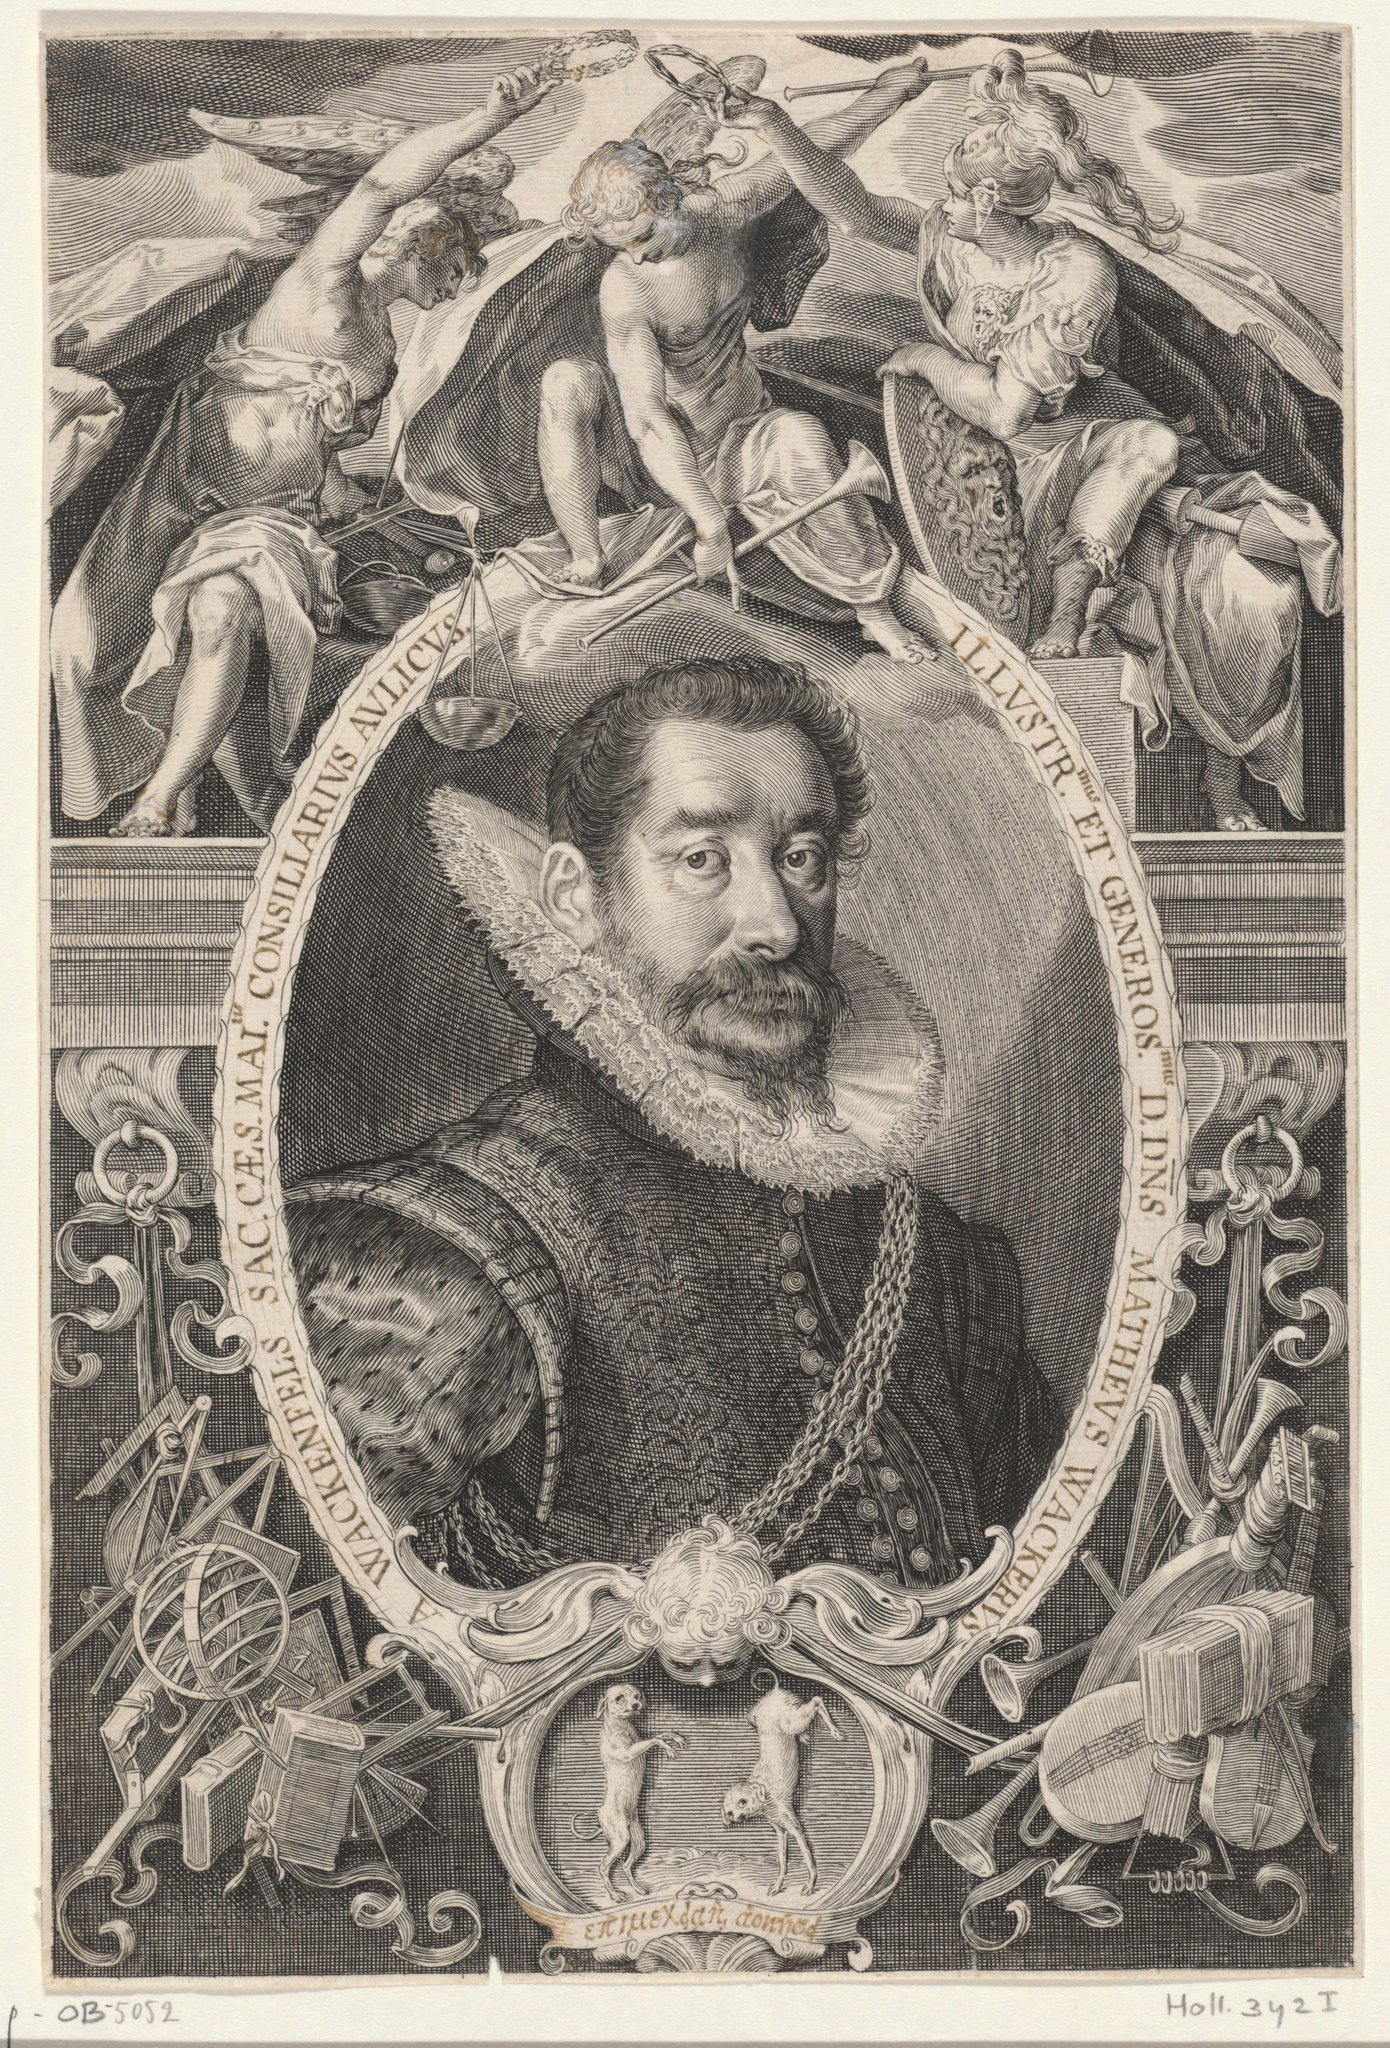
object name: print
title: Portret van Matthaeus Wacker von Wackenfels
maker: aegidius sadeler (ii)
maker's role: draughtsman, print maker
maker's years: 1568-1629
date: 1597-1629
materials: paper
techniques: engraving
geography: prague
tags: musical instruments; group of musical instruments, symbolic representations, allegories and emblems ~ science, 'scientia'; 'scienza', 'studio' (ripa), (story of) minerva (pallas, athena), neck-gear ~ clothing (with name) (+ men's clothes), justice; 'forza alla giustitia sottoposta', 'giustitia', 'giustitia retta', 'giustitia rigorosa', 'impietà e violenza soggetta alla giustitia' (ripa), fame; 'fama', 'fama buona', 'fama chiara' (ripa), dog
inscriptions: collector's mark: Lugt 240, inscription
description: Matthaeus Wacker von Wackenfels (evt. de broer van Johannes Matthaeus Wacker). Boven het portret drie allegorische figuren die lauwerkransen ophouden (Justitia, Fama en Minerva). Rond het portret attributen van wetenschap (links) en muziek (rechts). Middenonder een vignet met twee honden.